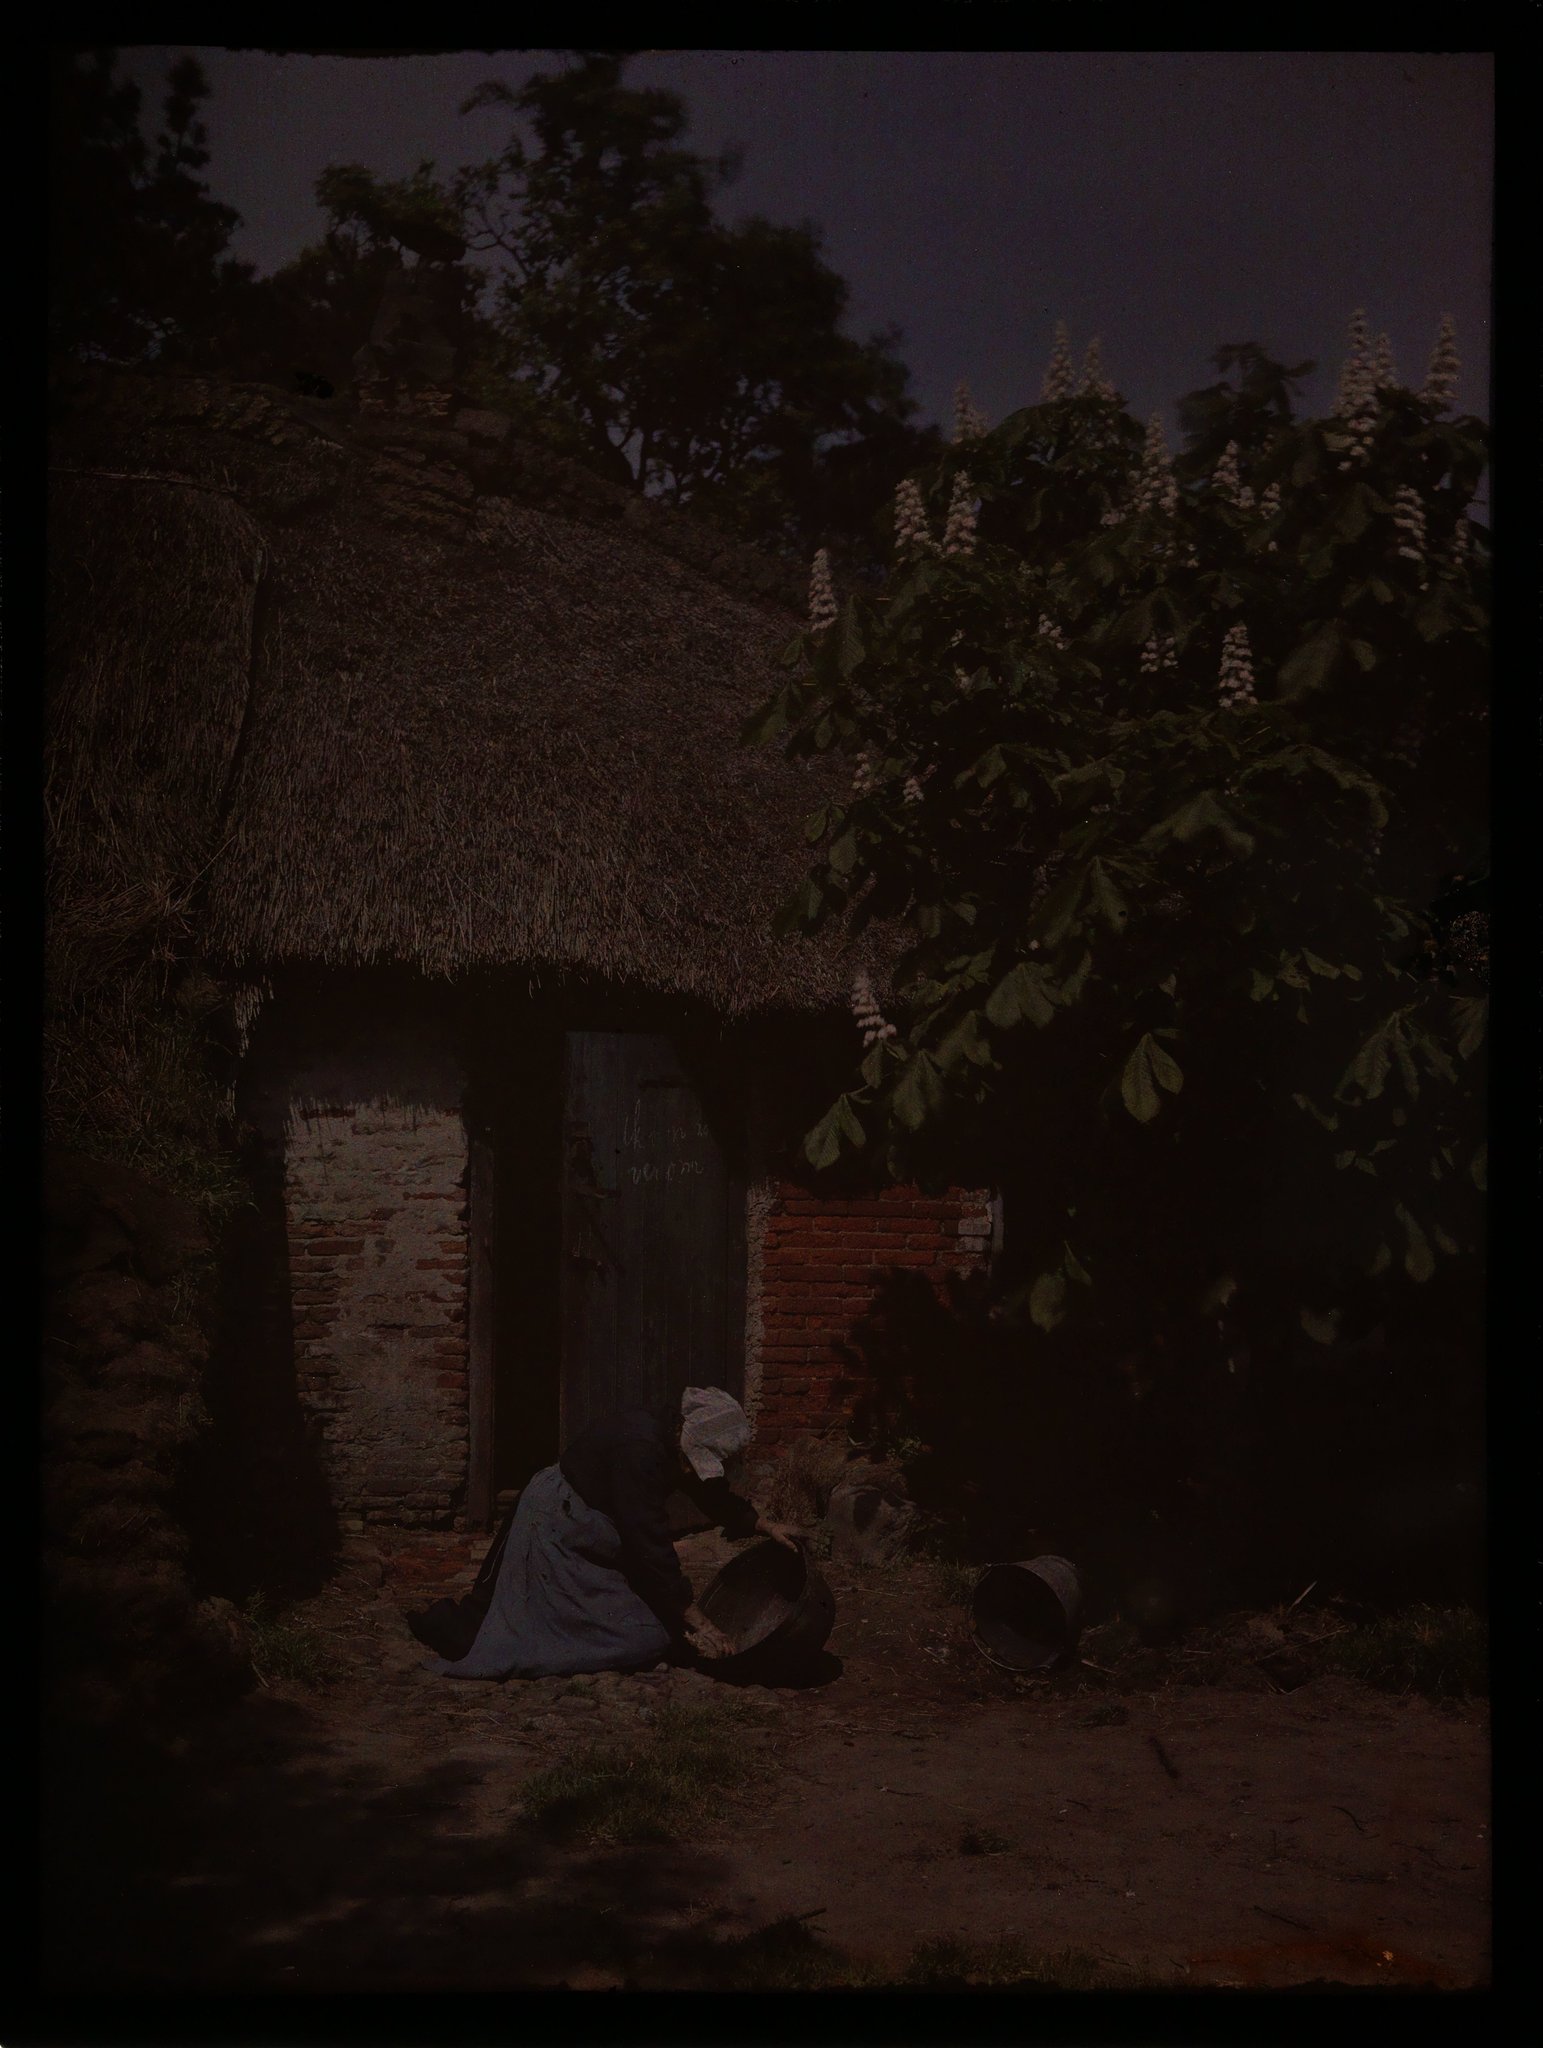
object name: photograph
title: Vrouw bij woning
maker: Anonymous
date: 1907-1935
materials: glass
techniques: autochrome process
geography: netherlands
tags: netherlands